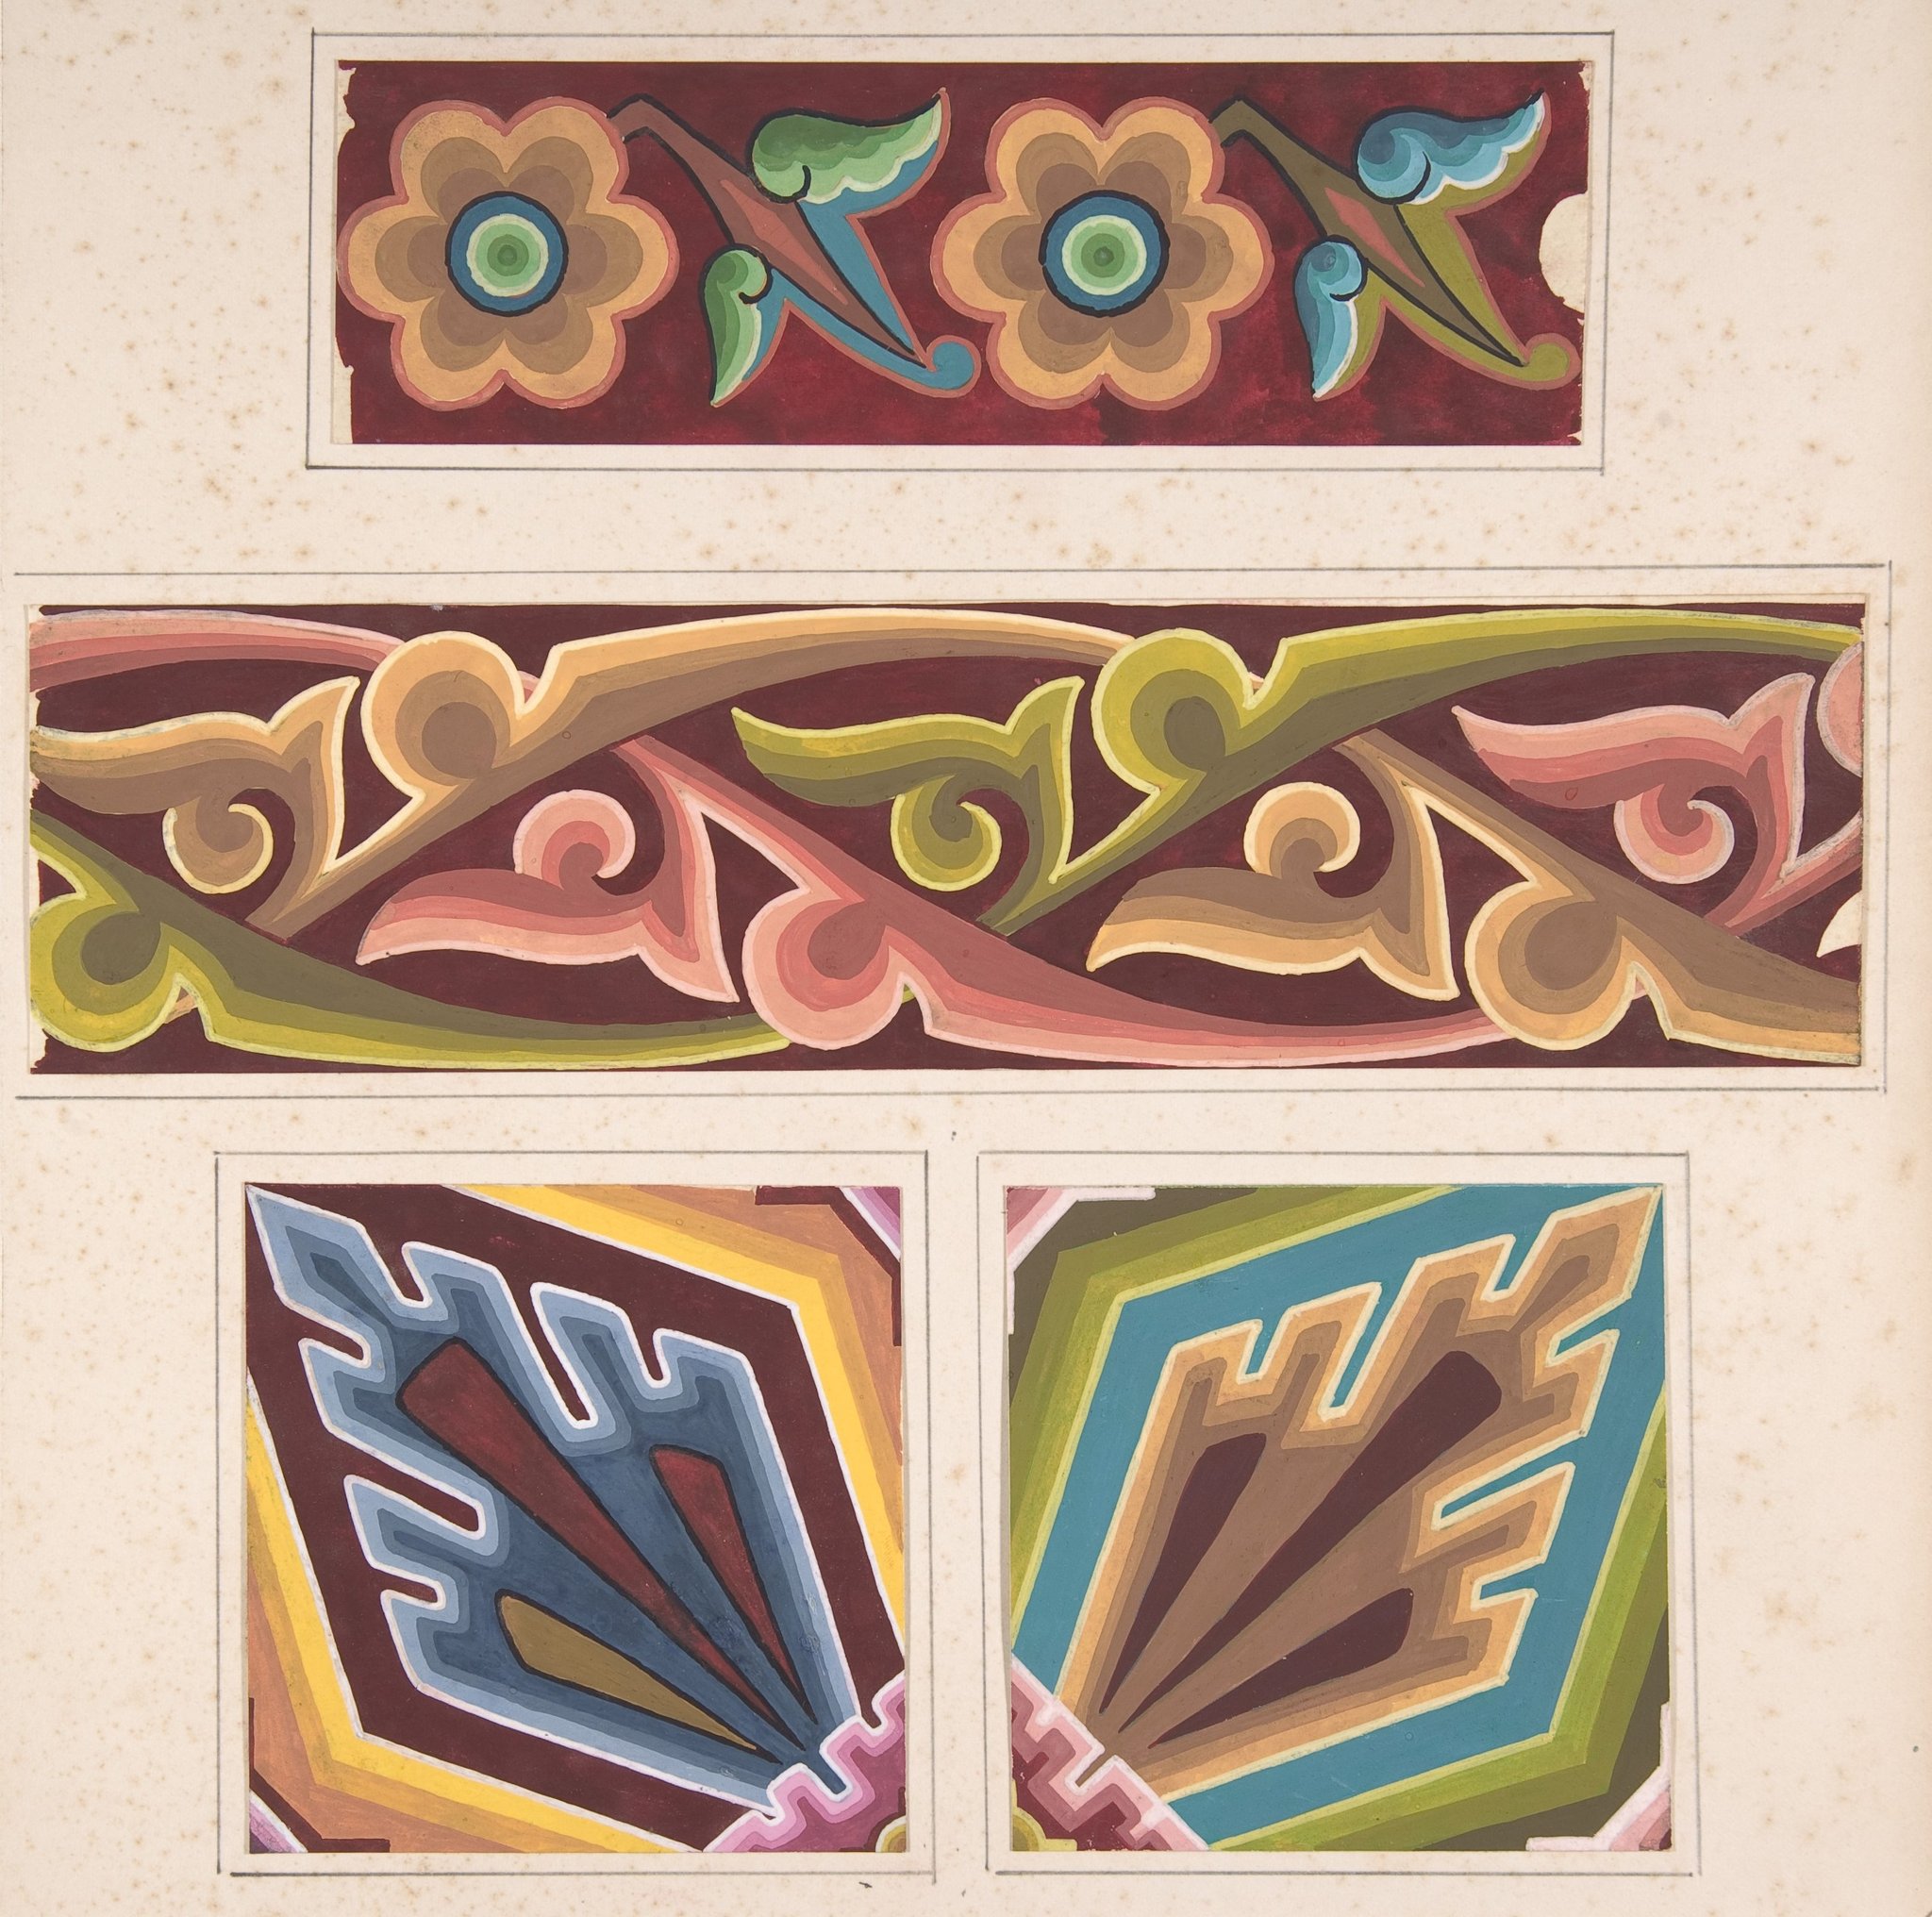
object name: drawing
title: Design drawing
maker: christopher dresser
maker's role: designer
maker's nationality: british, scottish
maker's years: 1834-1904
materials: gouache, graphite, ink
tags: ornament